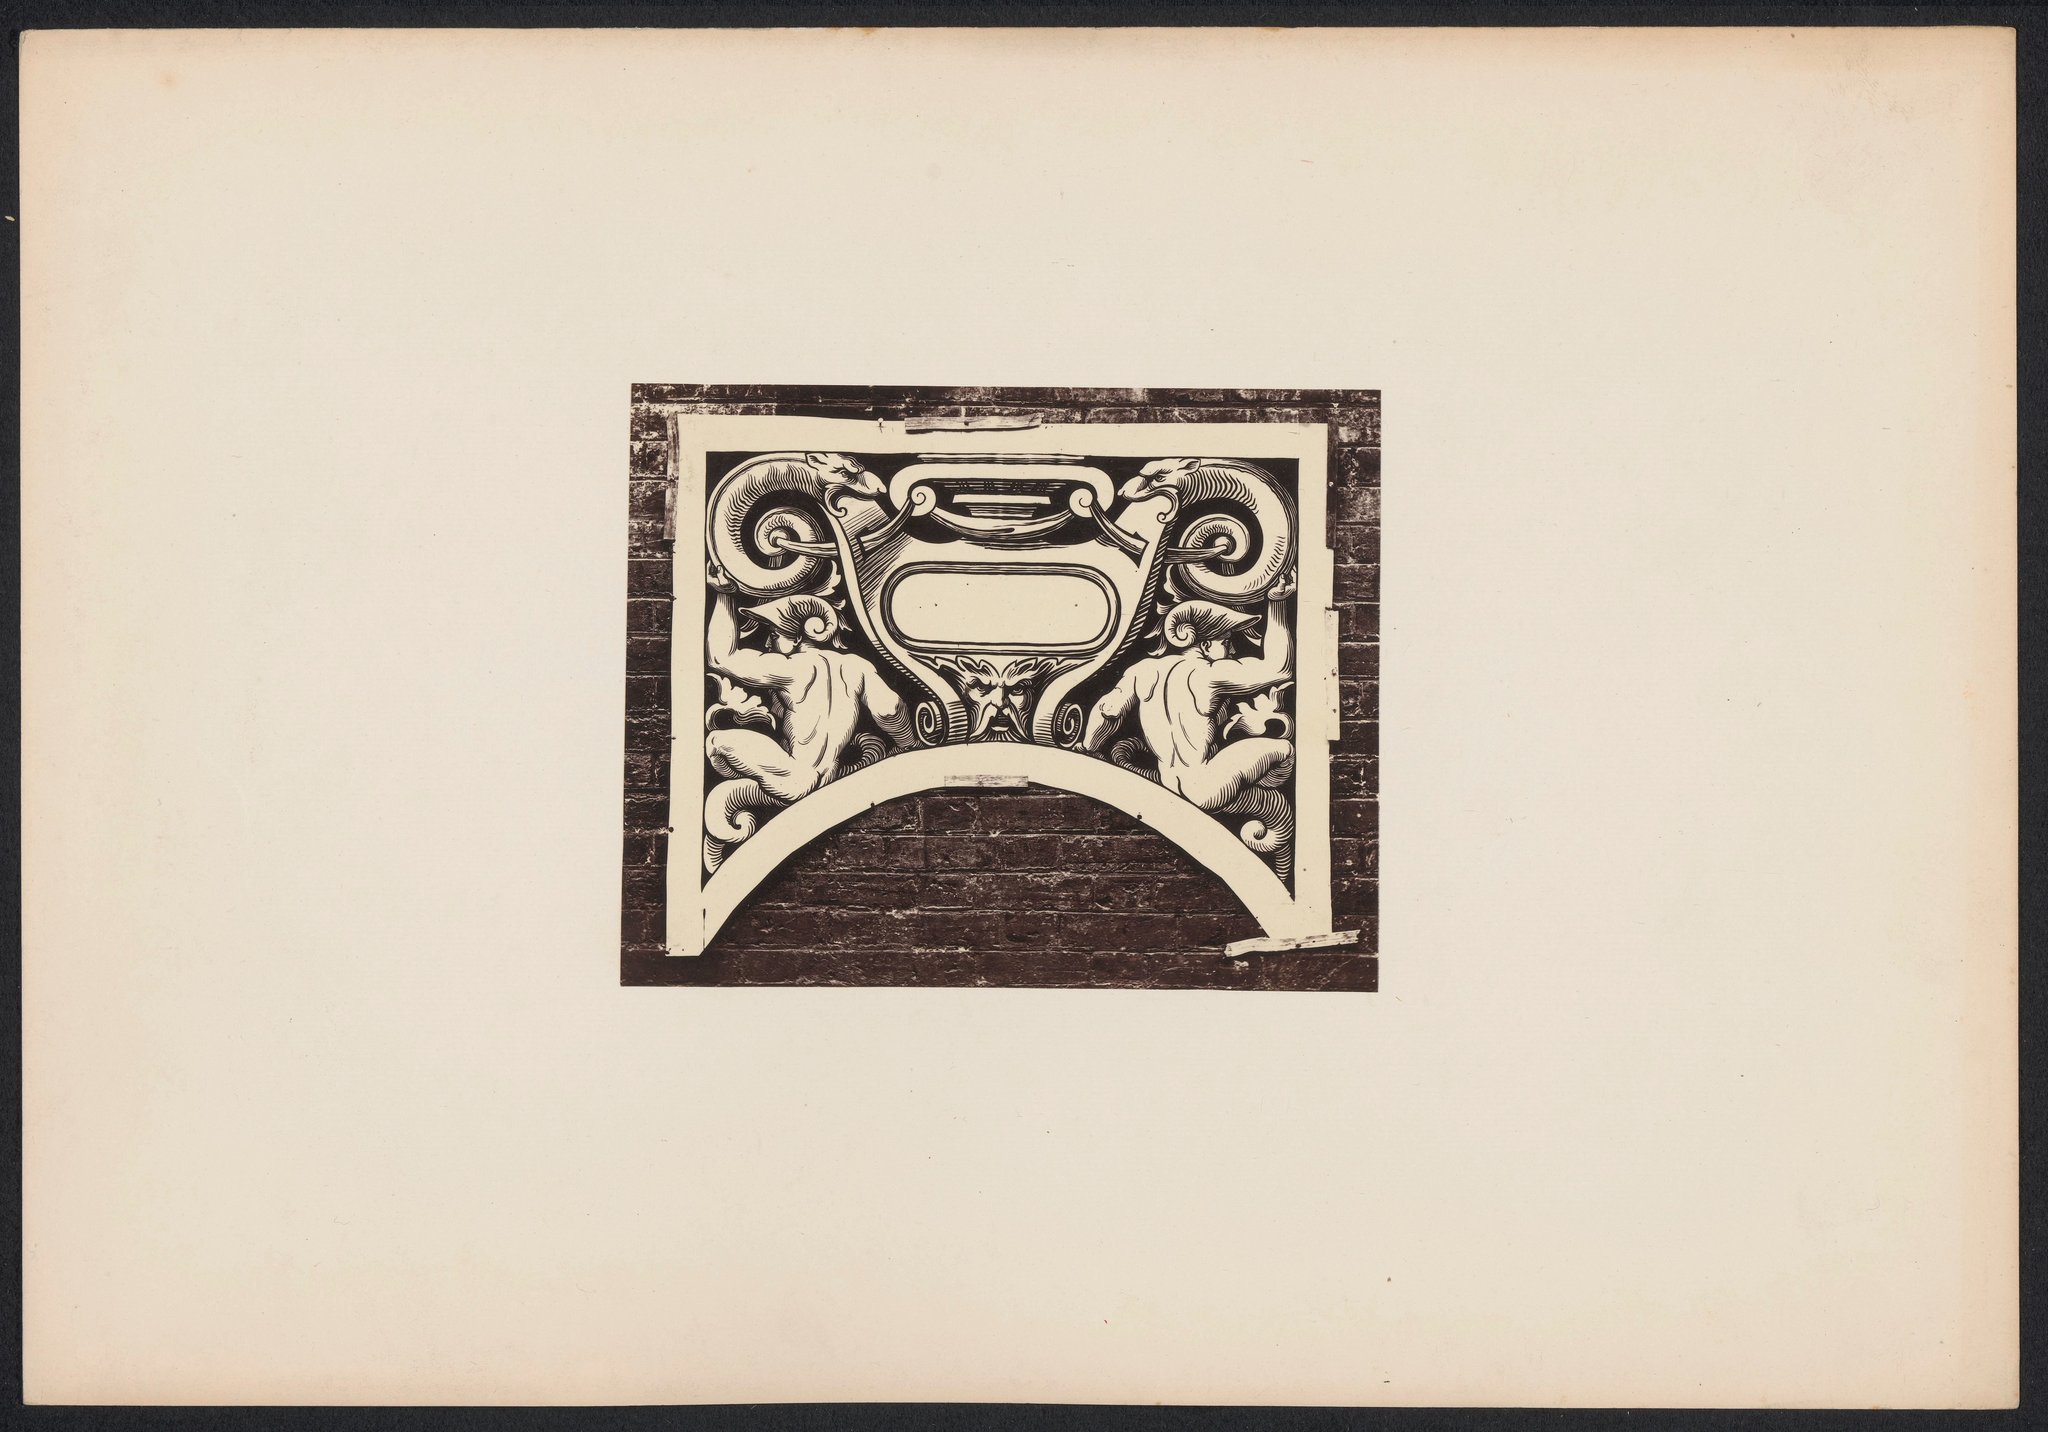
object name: photomontage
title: Ornamentprent met twee leunende figuren op een muur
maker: Anonymous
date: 1875-1900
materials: cardboard, photographic support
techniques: albumen print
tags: ornament ~ hybrid animals, other fantasy ornament, mask, mascaron ~ ornament, leaning figure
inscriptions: collector's mark: Lugt 3937